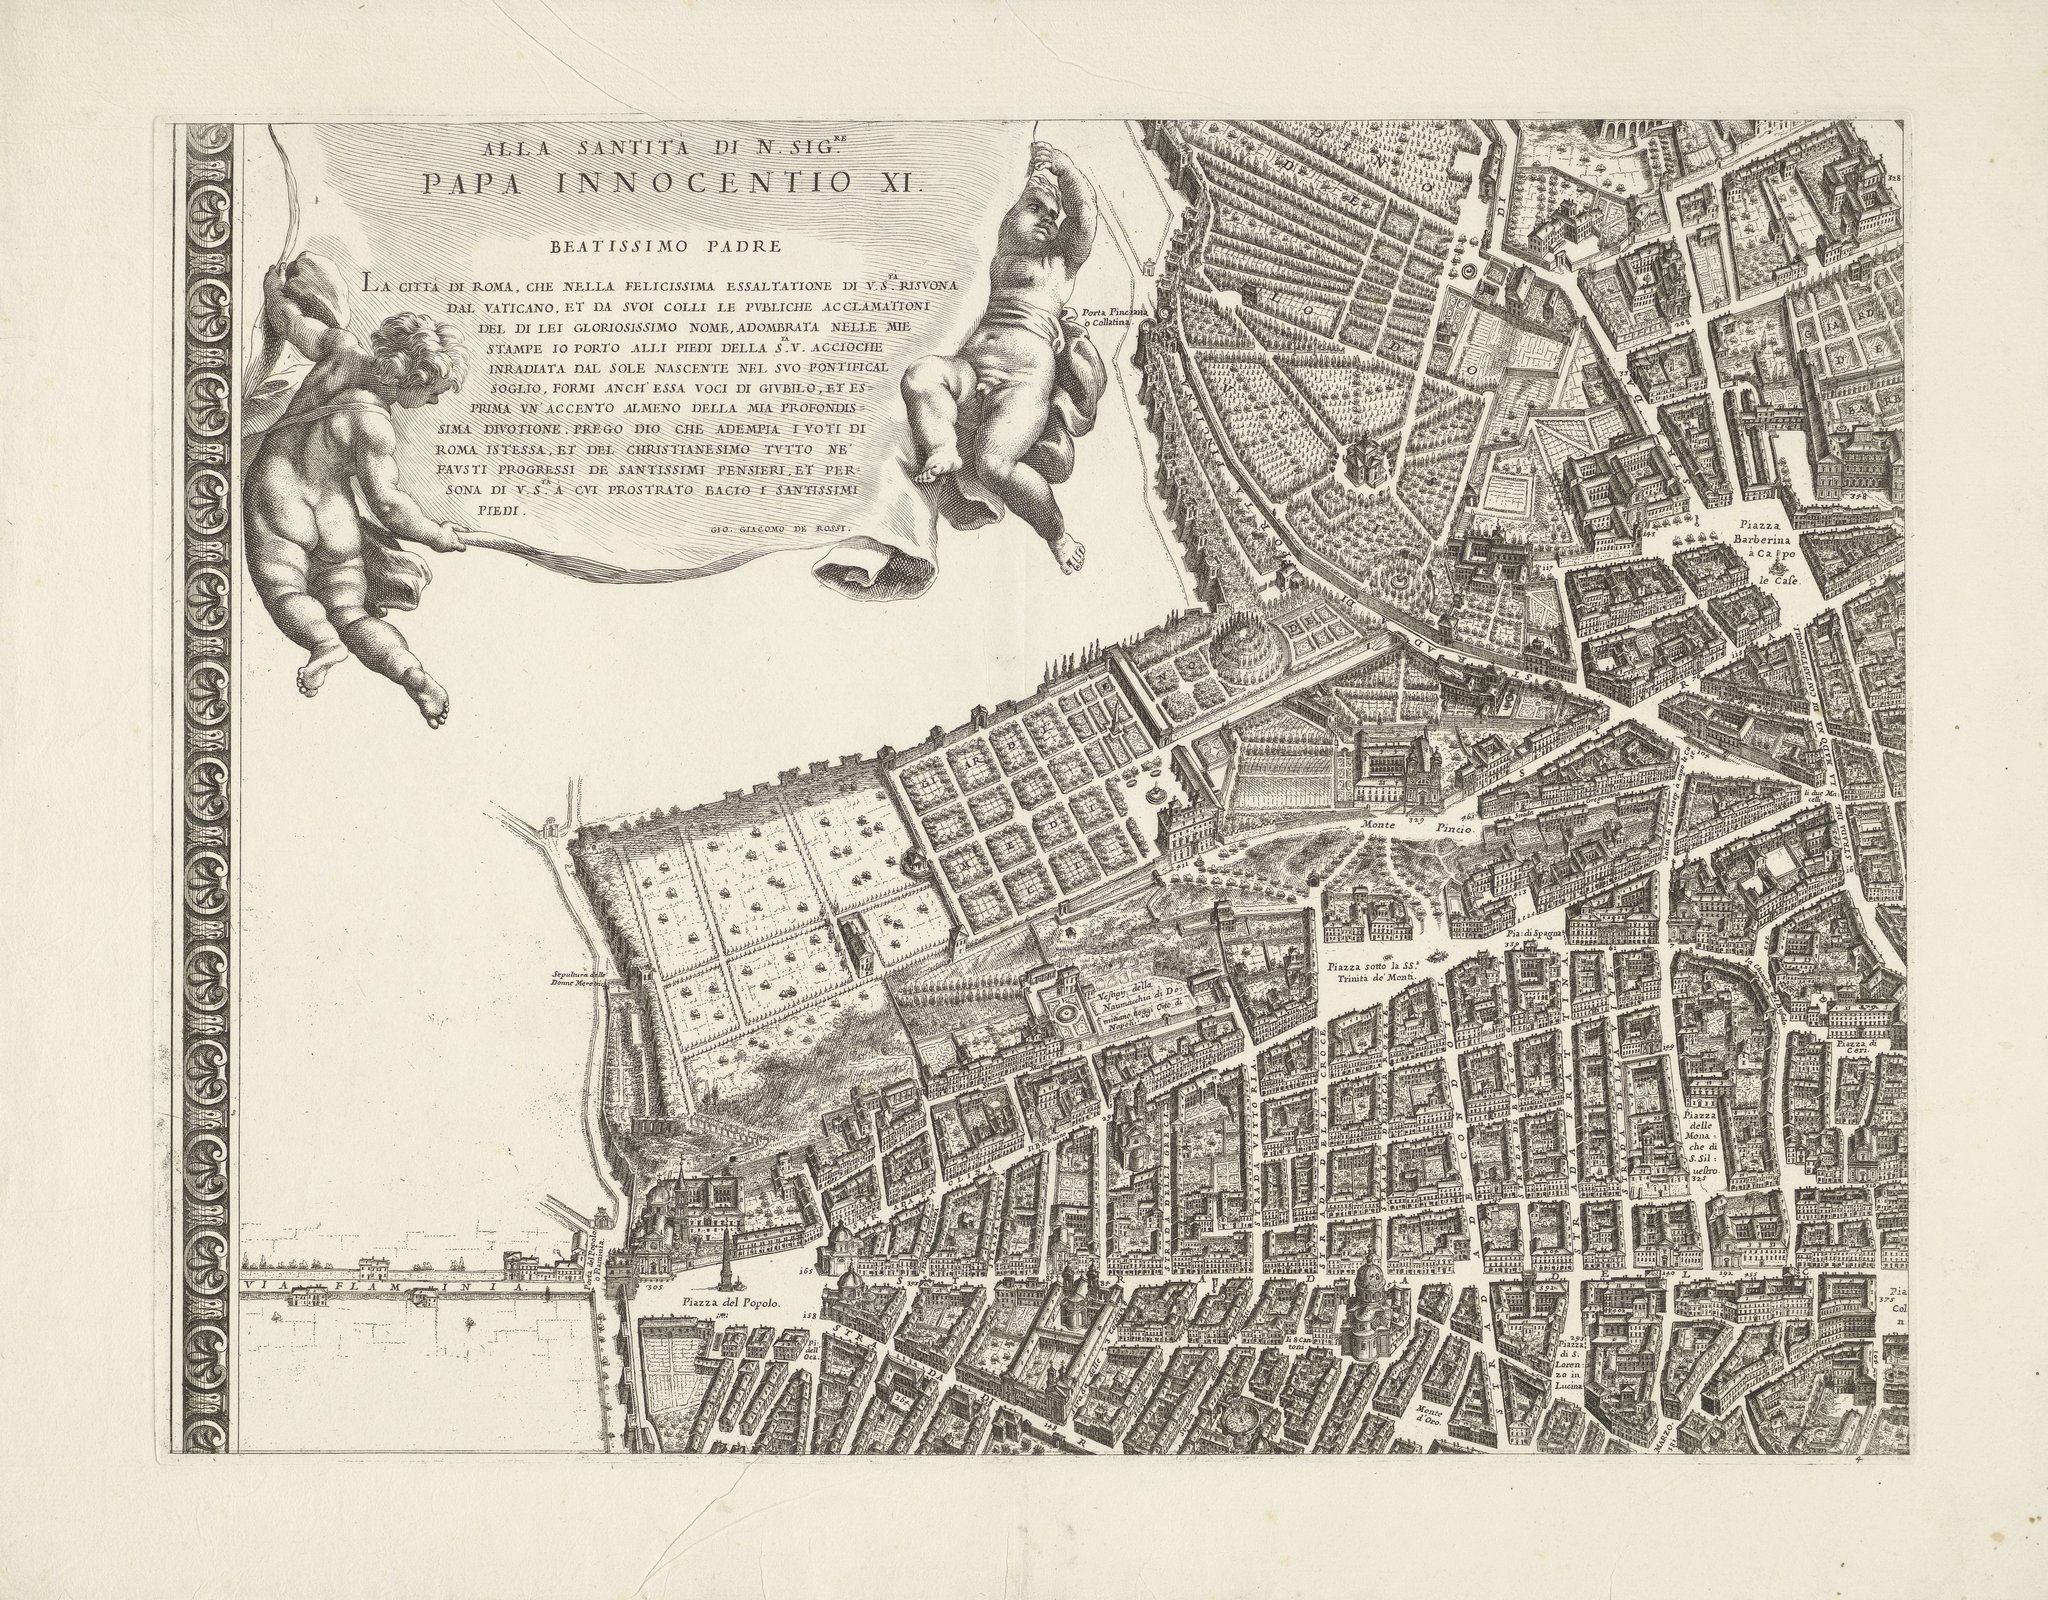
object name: print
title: Nuova piante et alzata della città di Roma con tutte le strade piazze et edificii (...)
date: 1676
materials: paper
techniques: etching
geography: vatican city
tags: maps, atlases, cupids: 'amores', 'amoretti', 'putti', rome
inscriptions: collector's mark: Lugt 2228